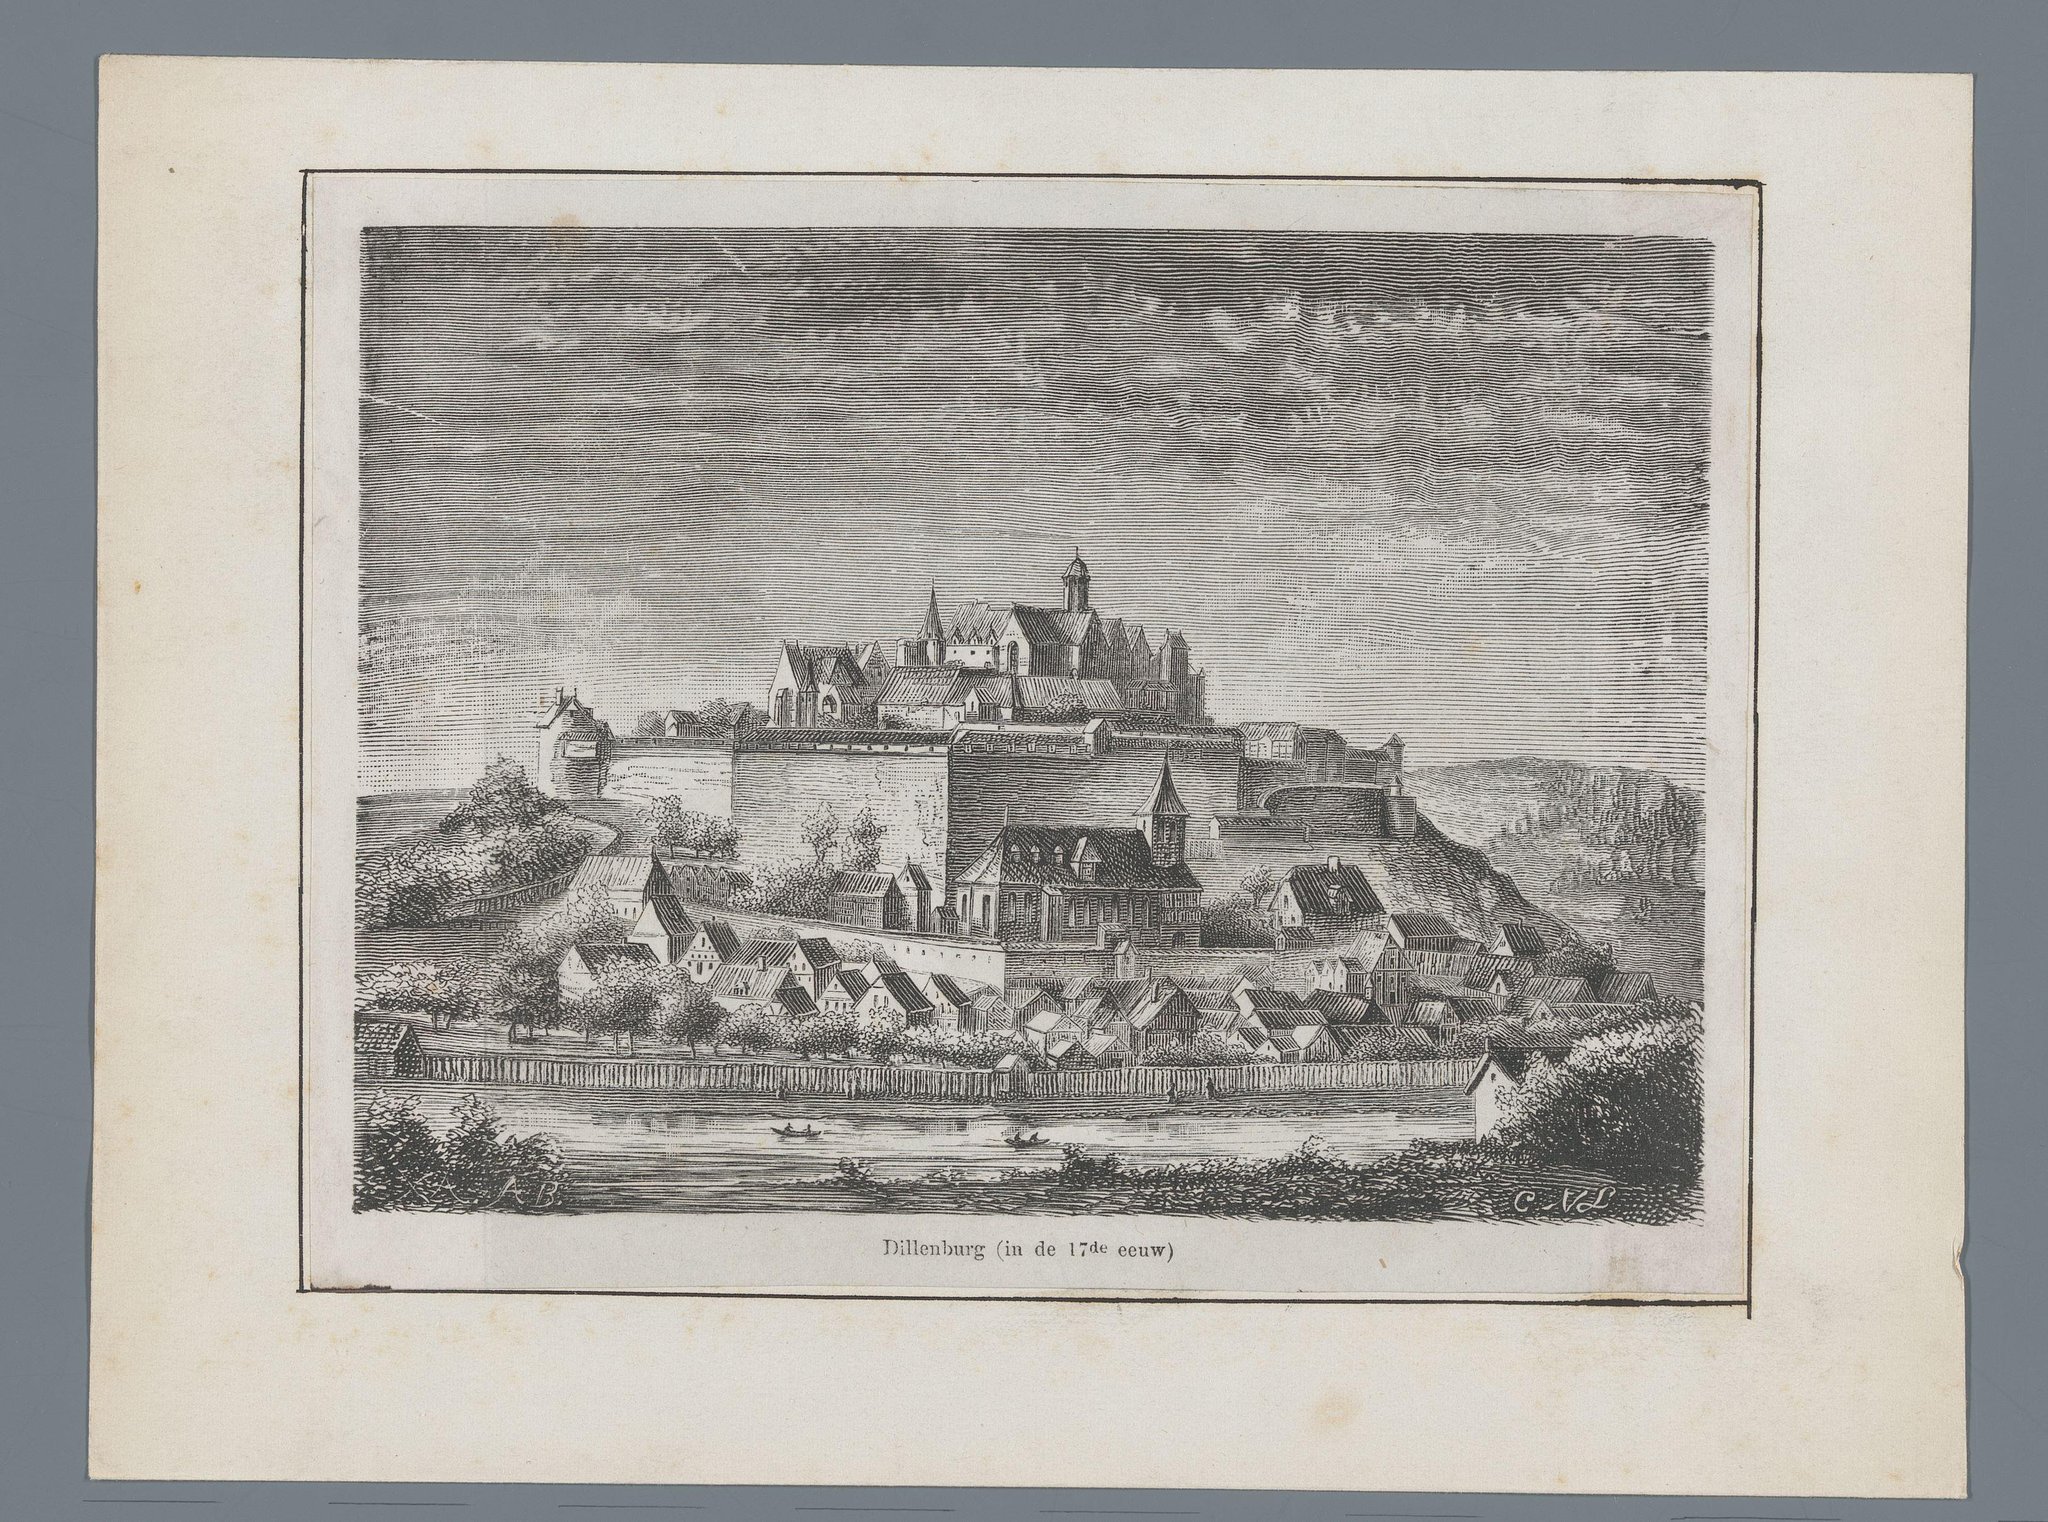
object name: print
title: Dillenburg (in de 17de eeuw)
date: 1841-1915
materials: paper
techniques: woodcut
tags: prospect of village, silhouette of village